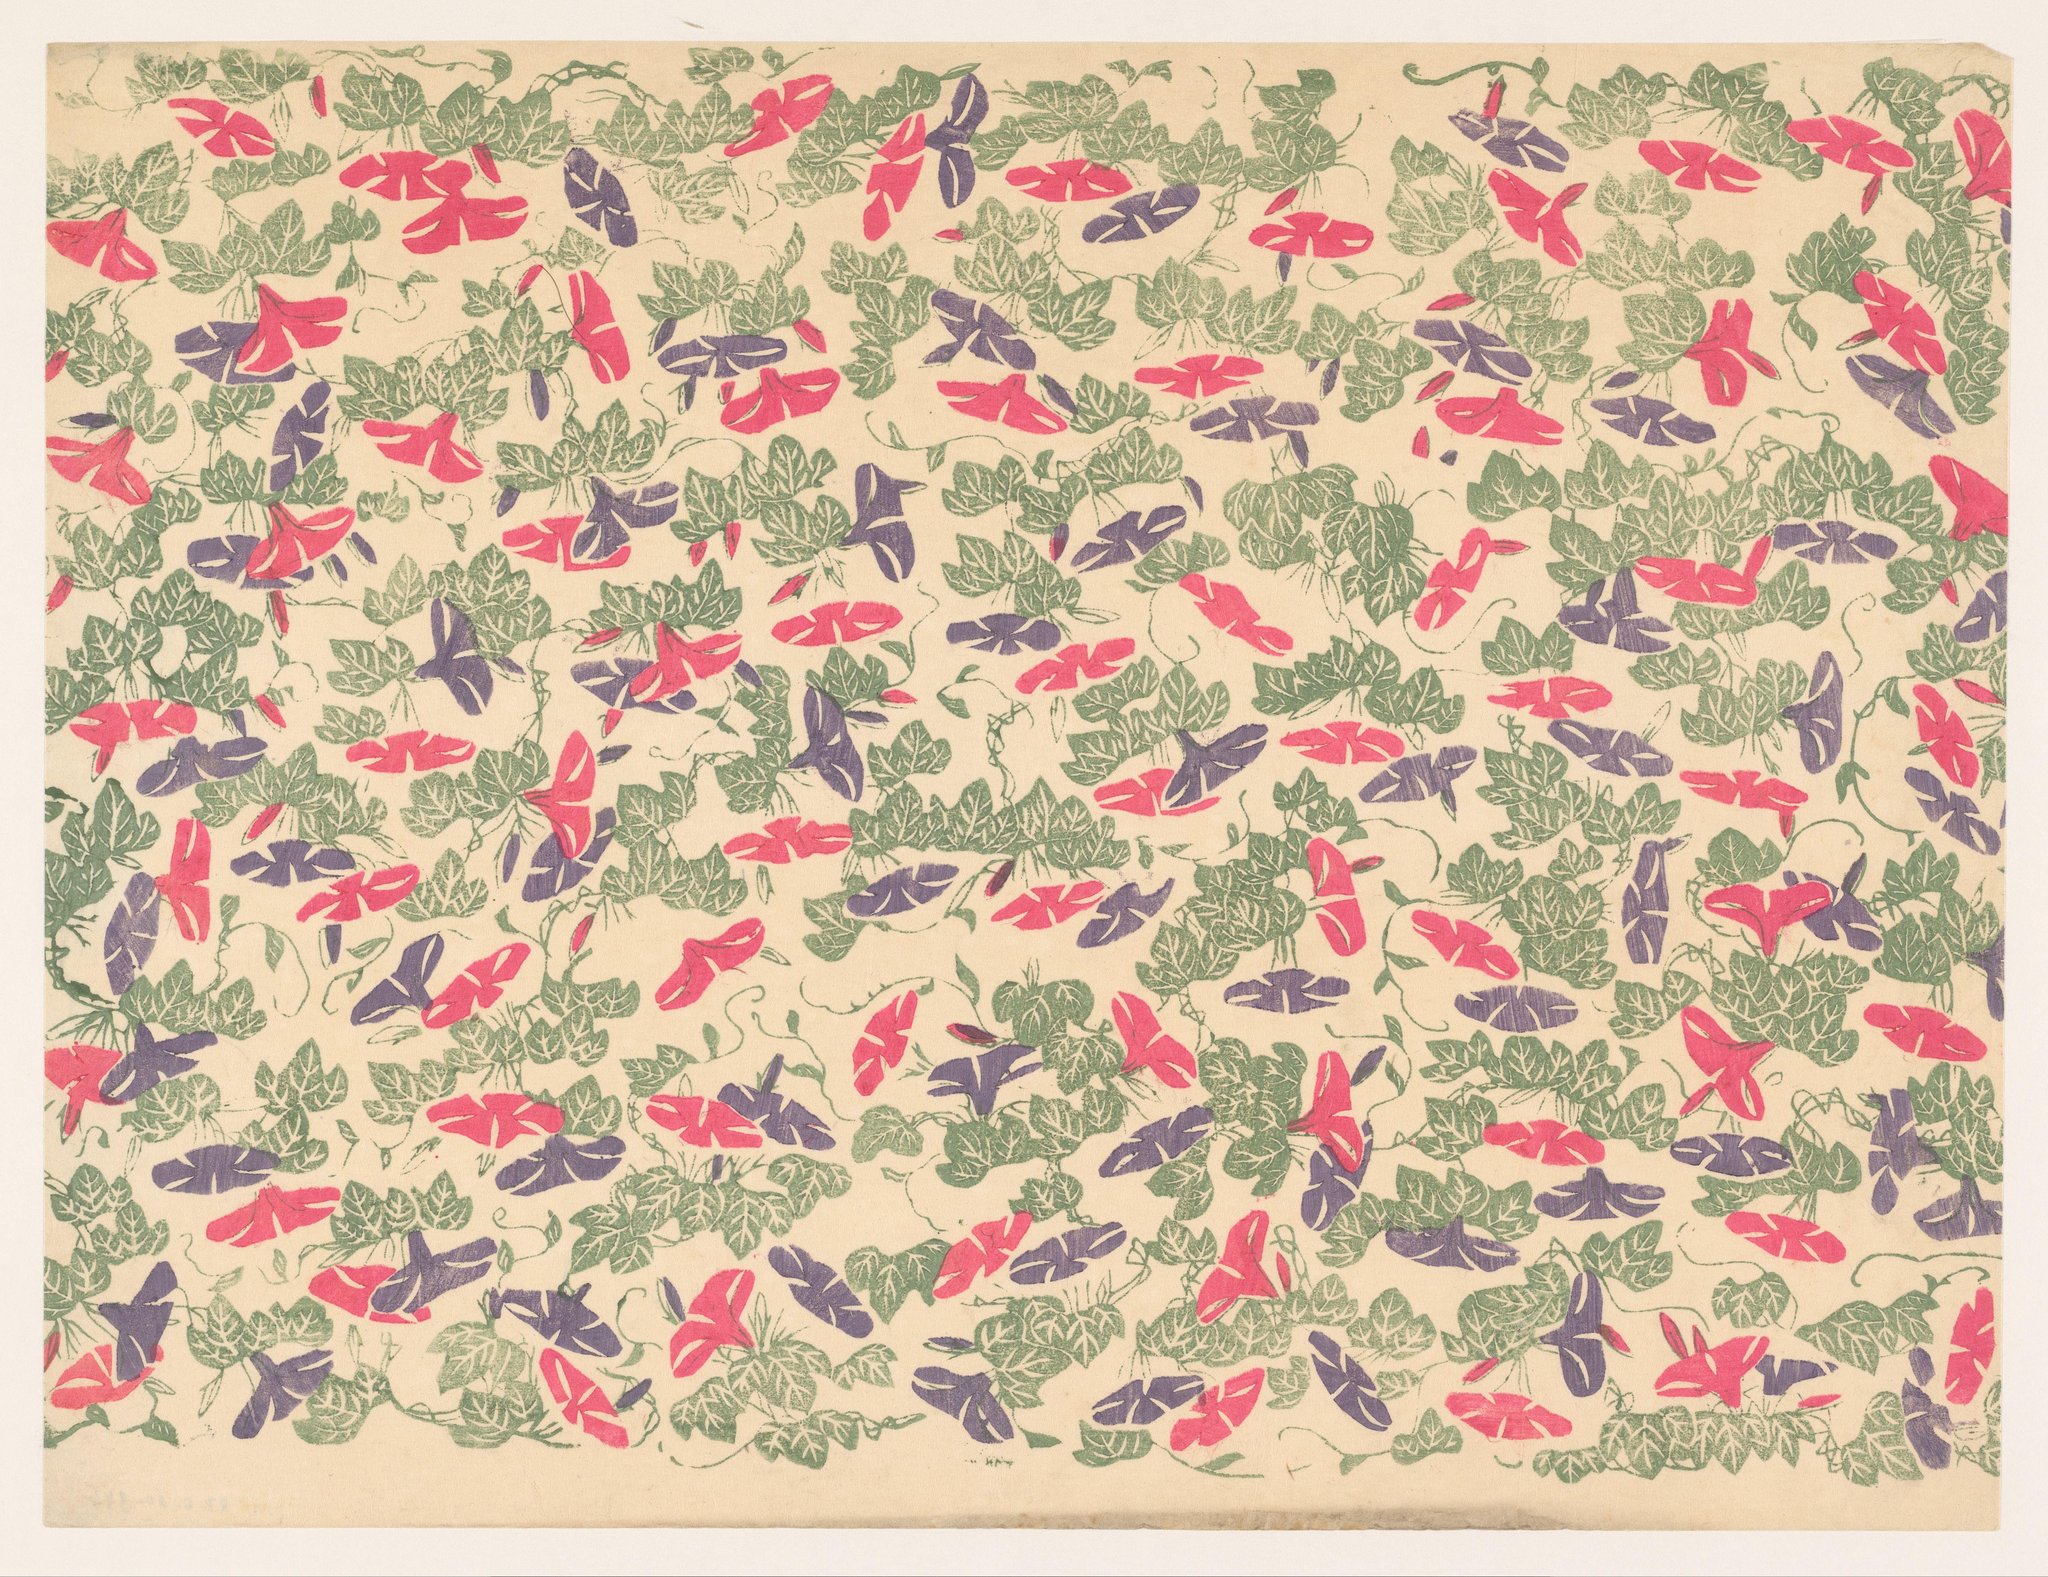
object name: decorated paper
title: Patroon van bladranken en bloemen van de winde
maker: Anonymous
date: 1860-1930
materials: paper, paint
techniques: woodcut, printing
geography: japan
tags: flowers: morning glory, ornament derived from plant forms